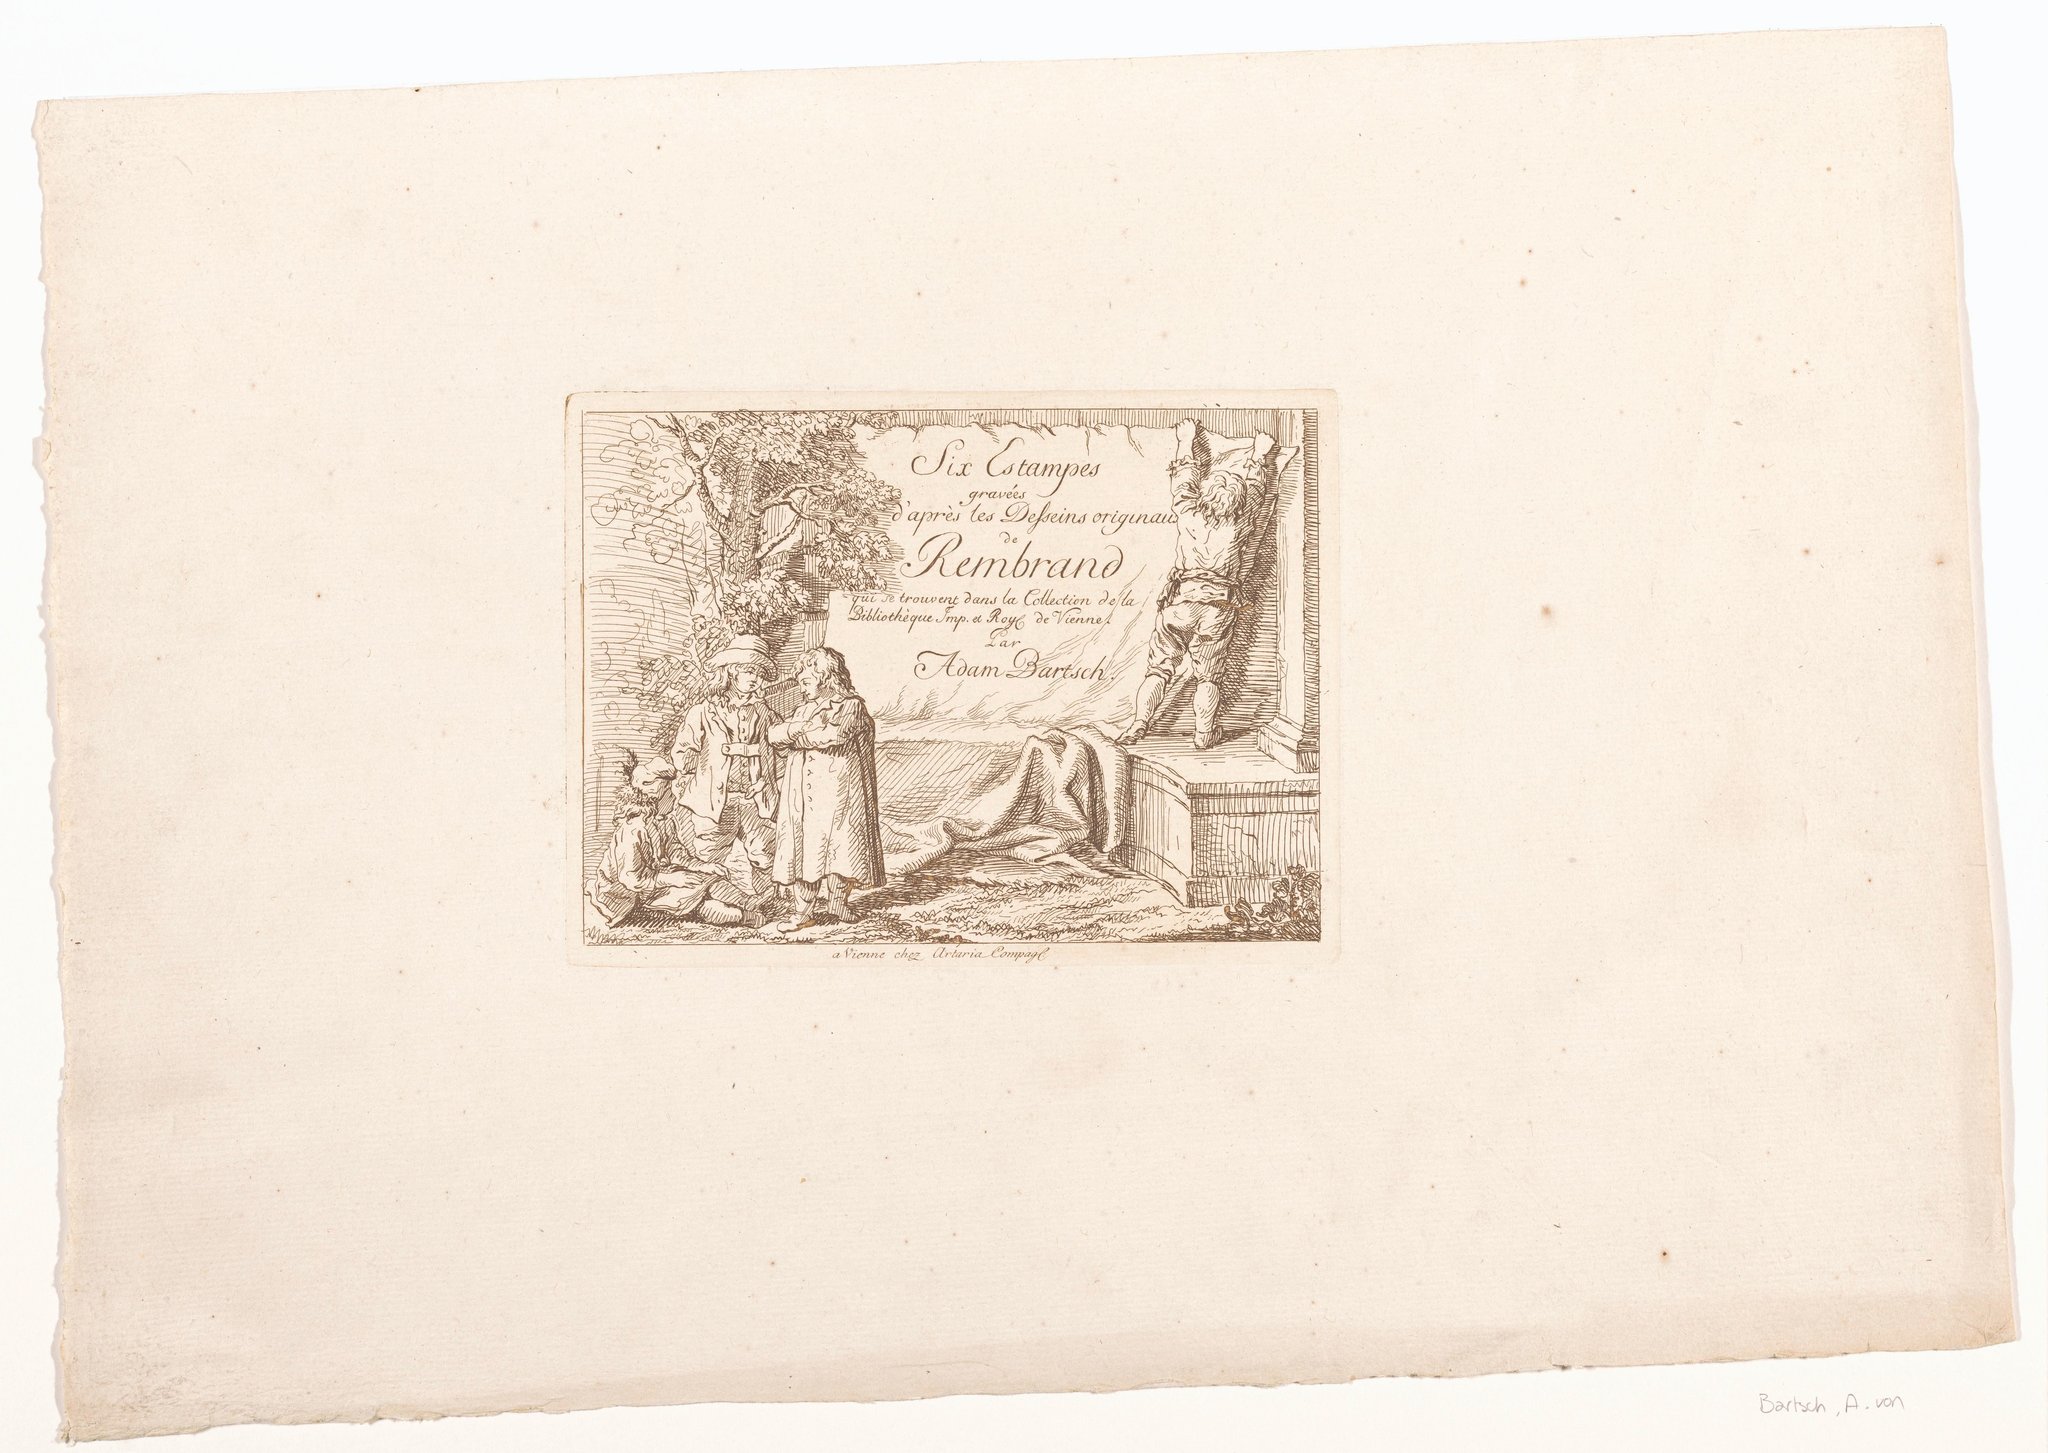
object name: print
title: Six estampes gravées d'après les desseins originaux de Rembrand qui se trouvent dans la collection de la Bibliothèque Imp. et Roy. de Vienne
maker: adam von bartsch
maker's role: print maker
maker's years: 1757-1821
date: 1782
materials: paper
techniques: etching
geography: vienna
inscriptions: collector's mark: Lugt 240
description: Titelprent van de serie 'Six estampes gravées d'après les desseins originaux de Rembrand qui se trouvent dans la collection de la Bibliothèque Imp. et Roy. de Vienne', bestaand uit een titelprent en zes prenten.